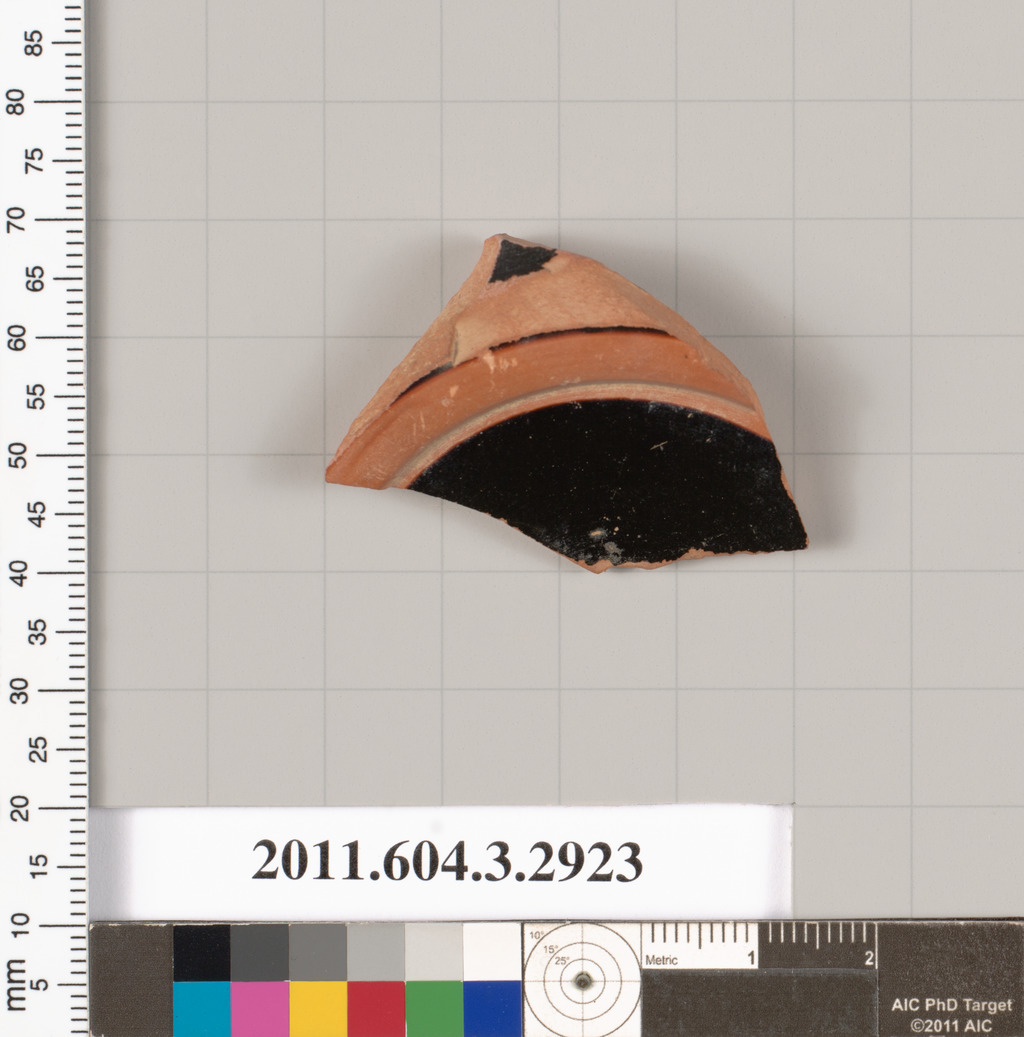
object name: undetermined closed shape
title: Terracotta fragment of a closed shape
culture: greek, attic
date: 600-401 BCE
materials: terracotta